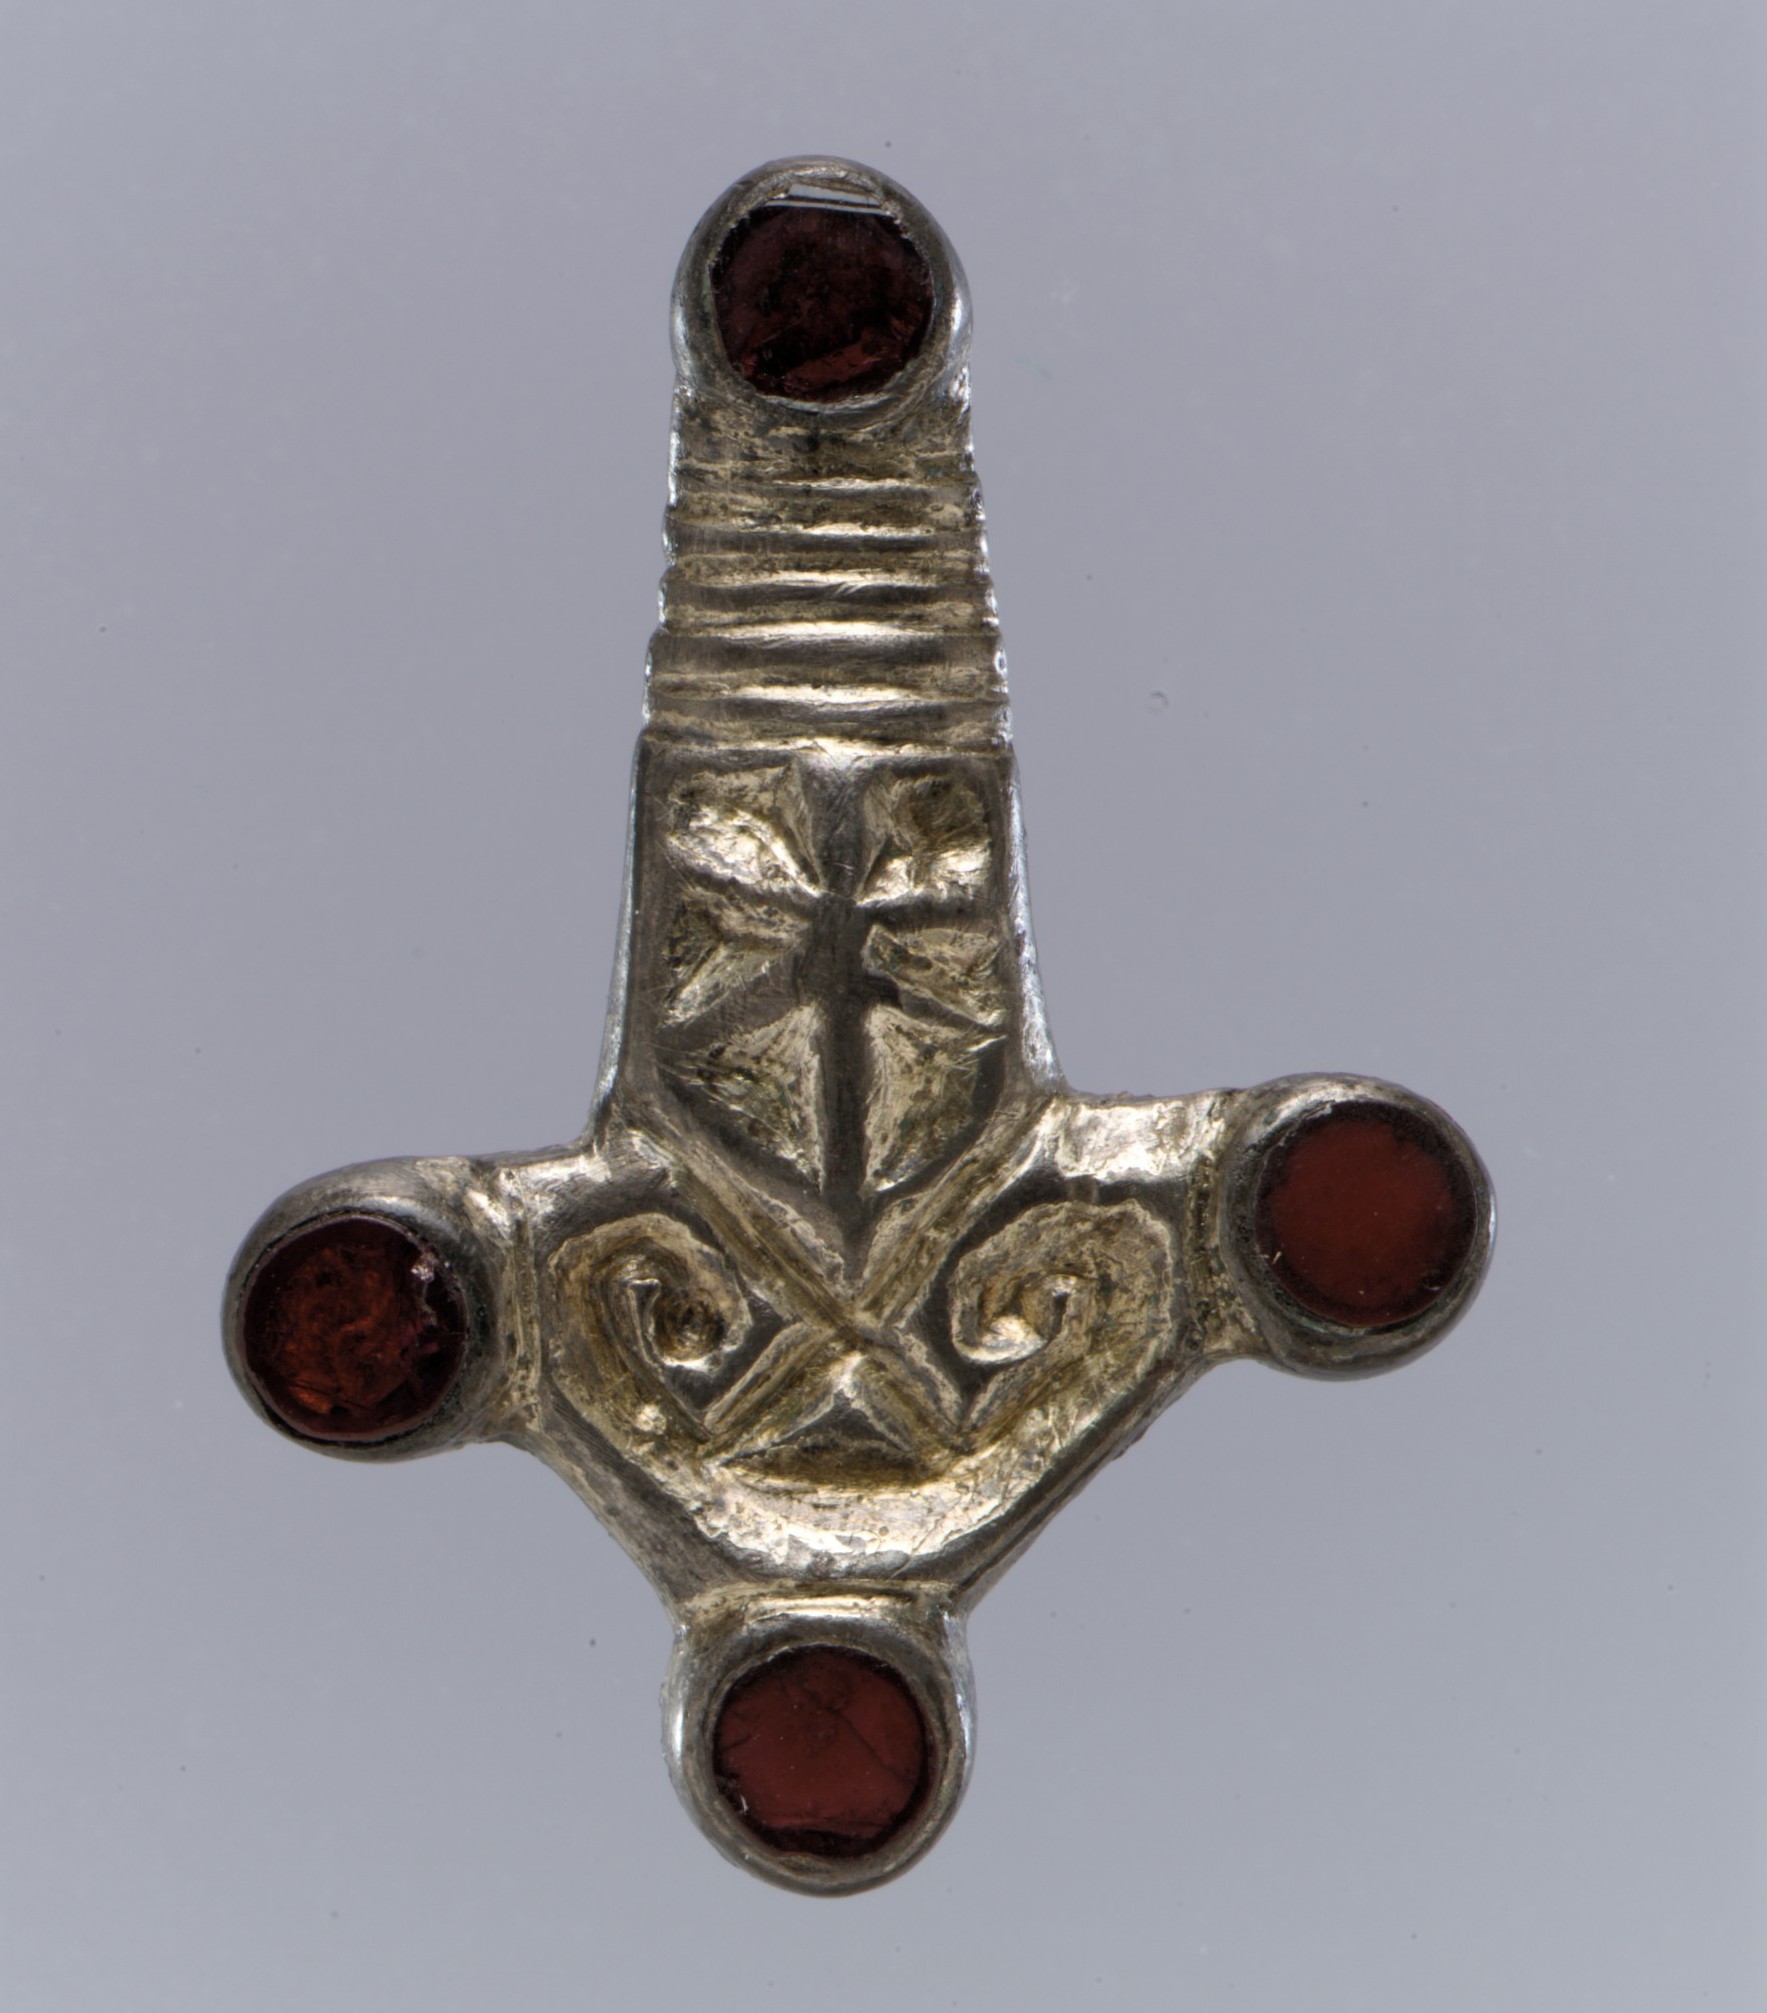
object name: brooch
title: Bow Brooch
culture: frankish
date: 450-500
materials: garnet, silver gilt